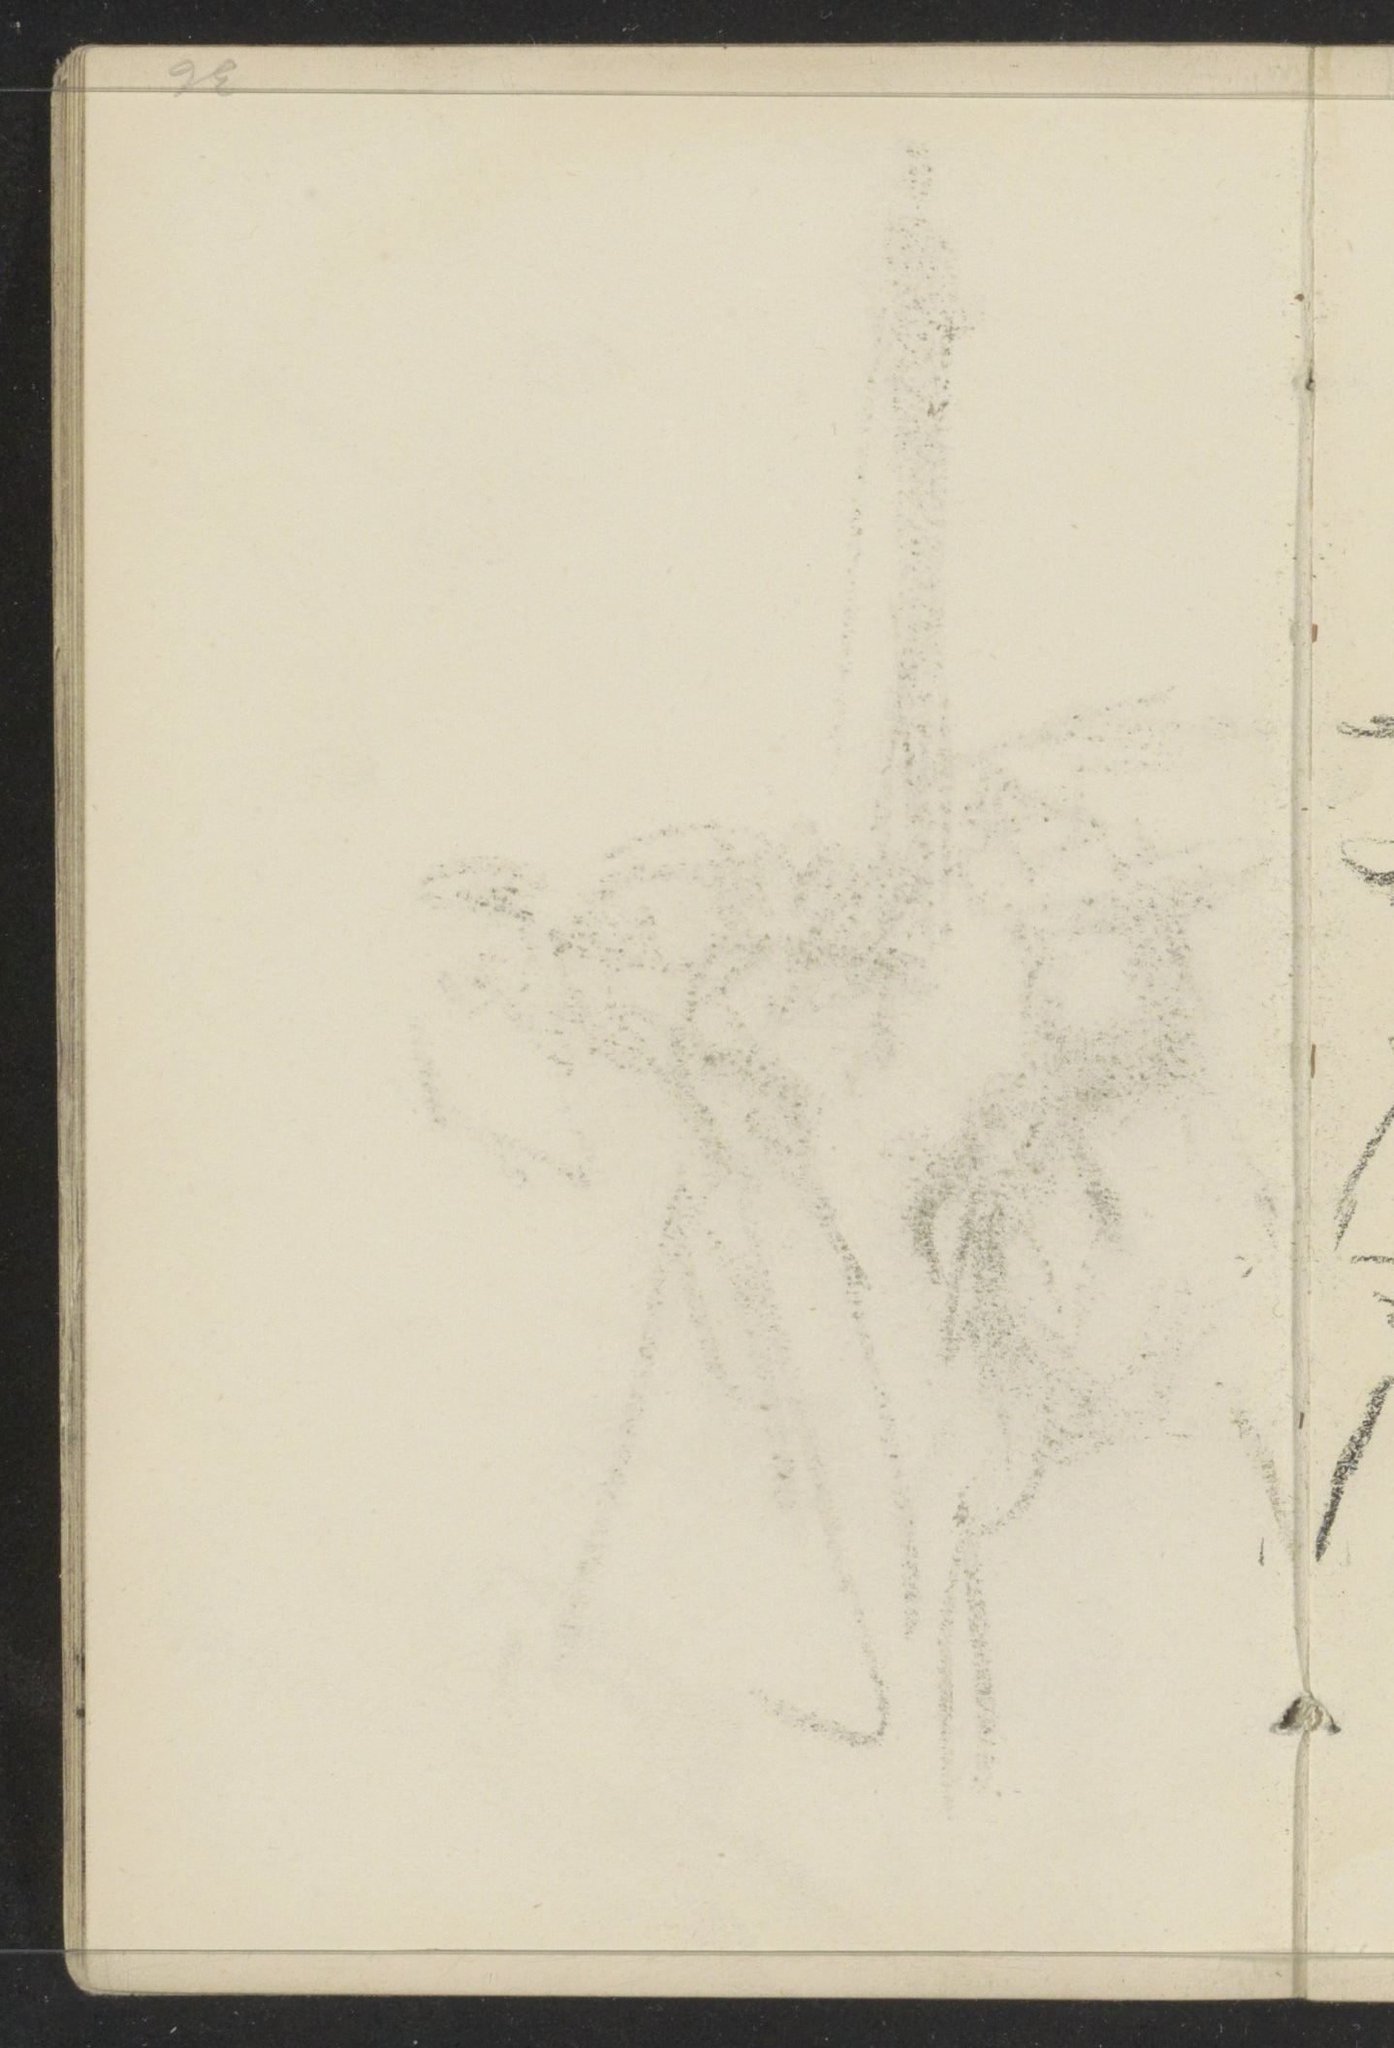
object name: sketchbook leaf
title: Abklatsch van de krijttekening op blad 8 recto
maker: isaac israels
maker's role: draughtsman, painter, print maker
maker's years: 1865-1934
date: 1887-1934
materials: paper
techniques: printmaking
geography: paris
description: Blad 7 verso uit schetsboek LIX met 21 bladen.